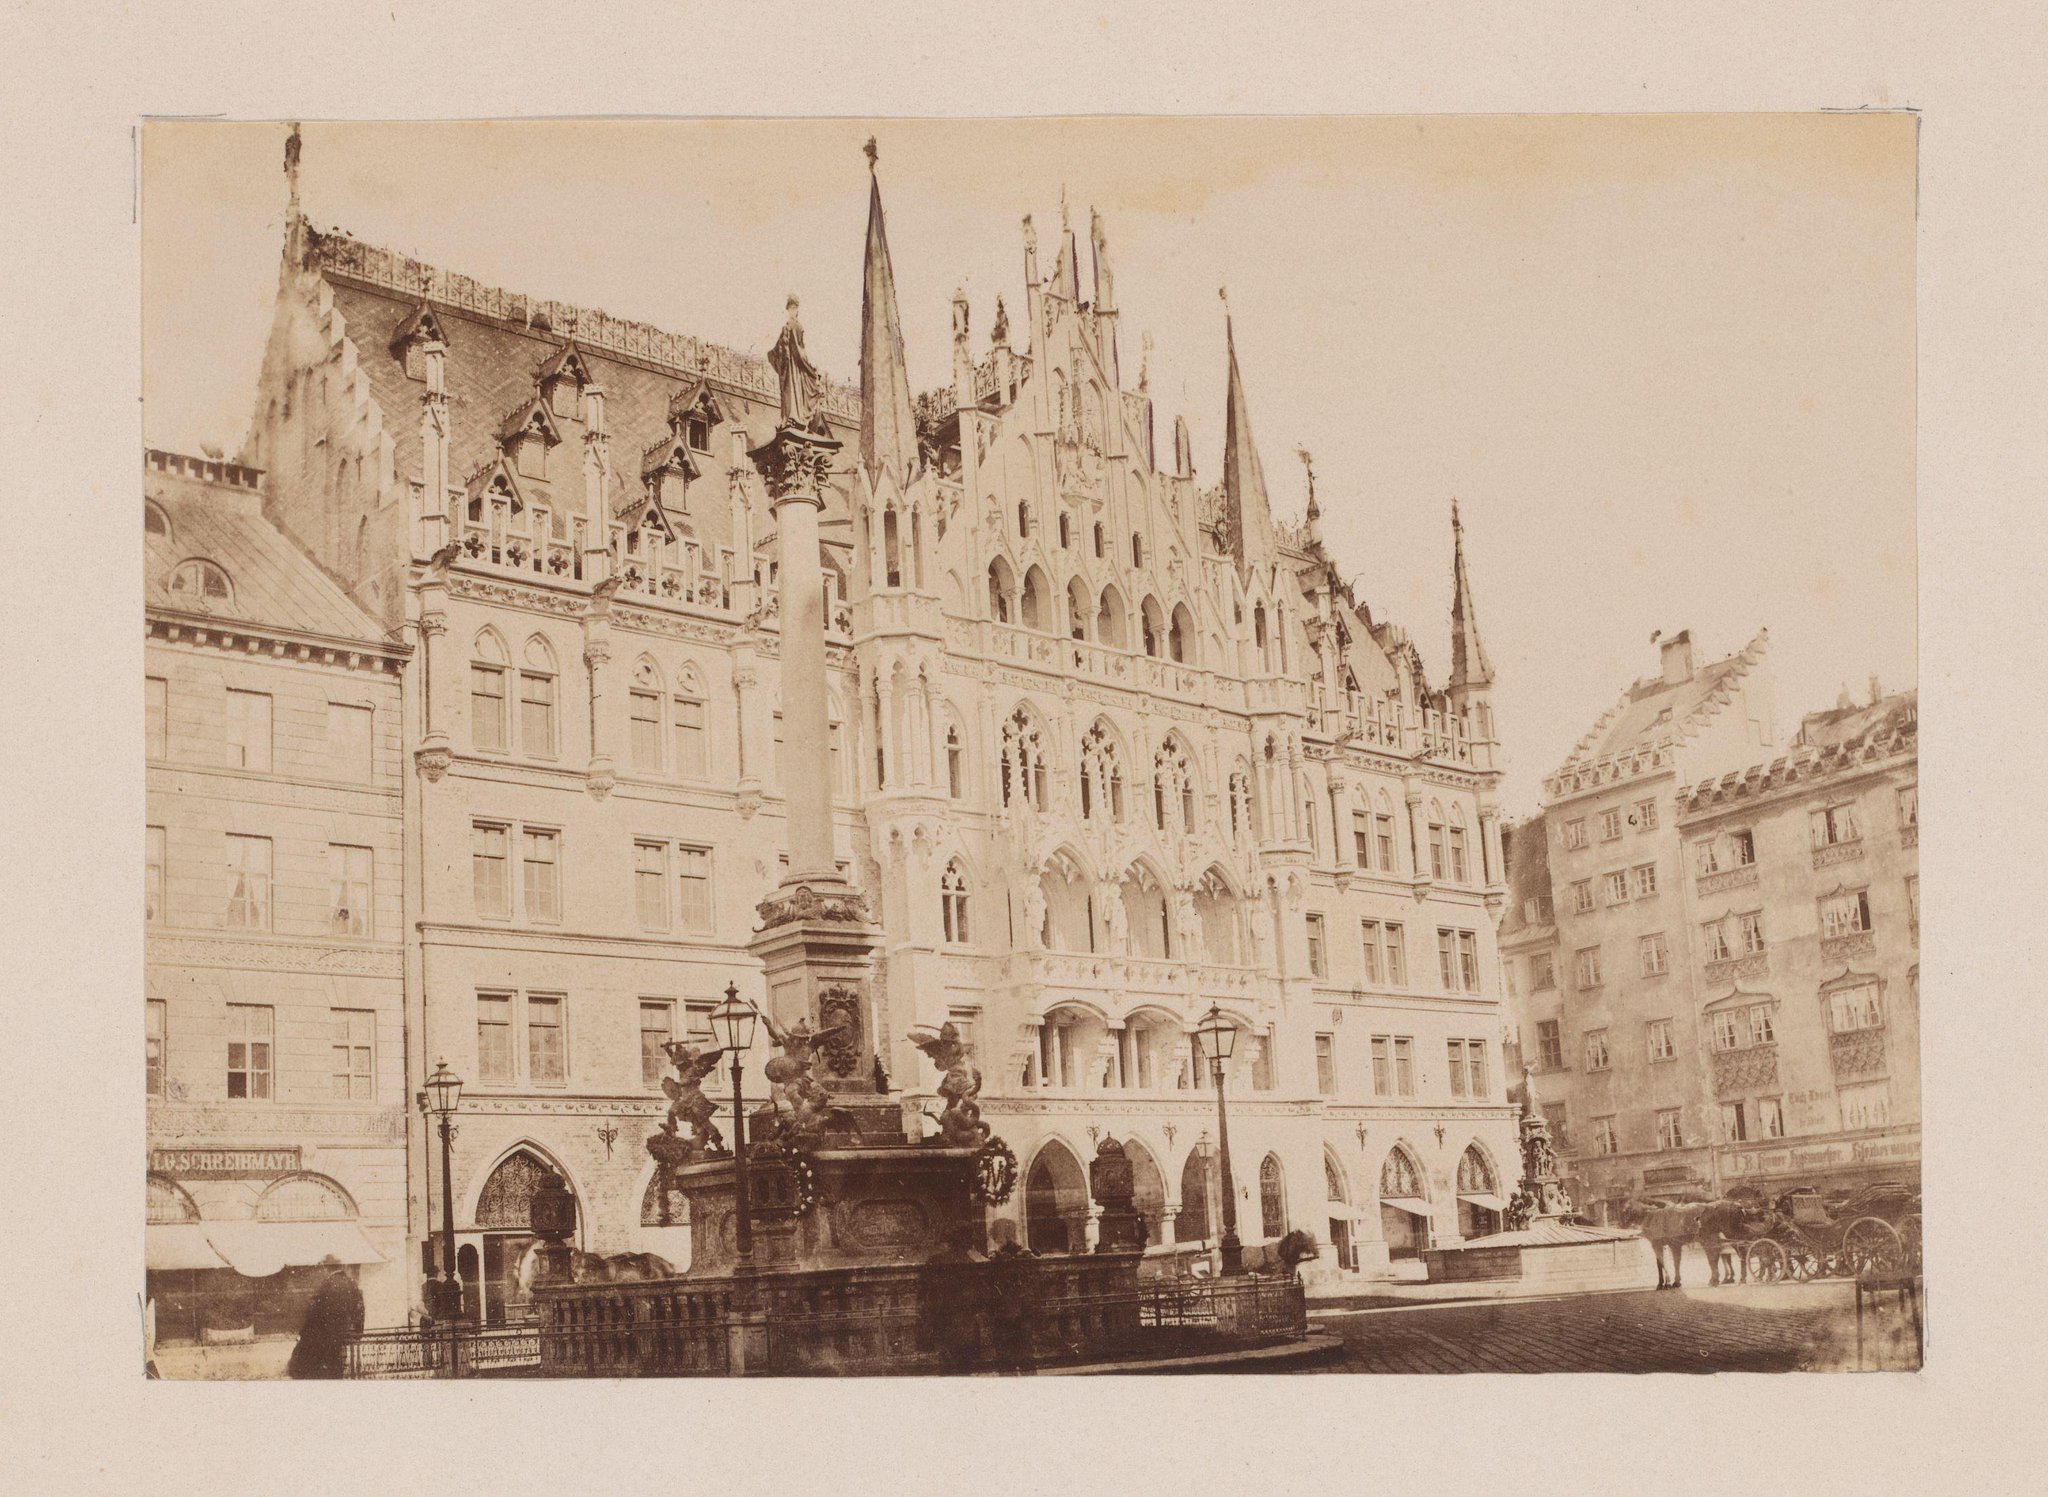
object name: photograph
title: Foto van groot gebouw in een stad, Bazel [?], Zwitserland [?]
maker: Anonymous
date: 1880-1910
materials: paper, photographic support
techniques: albumen print